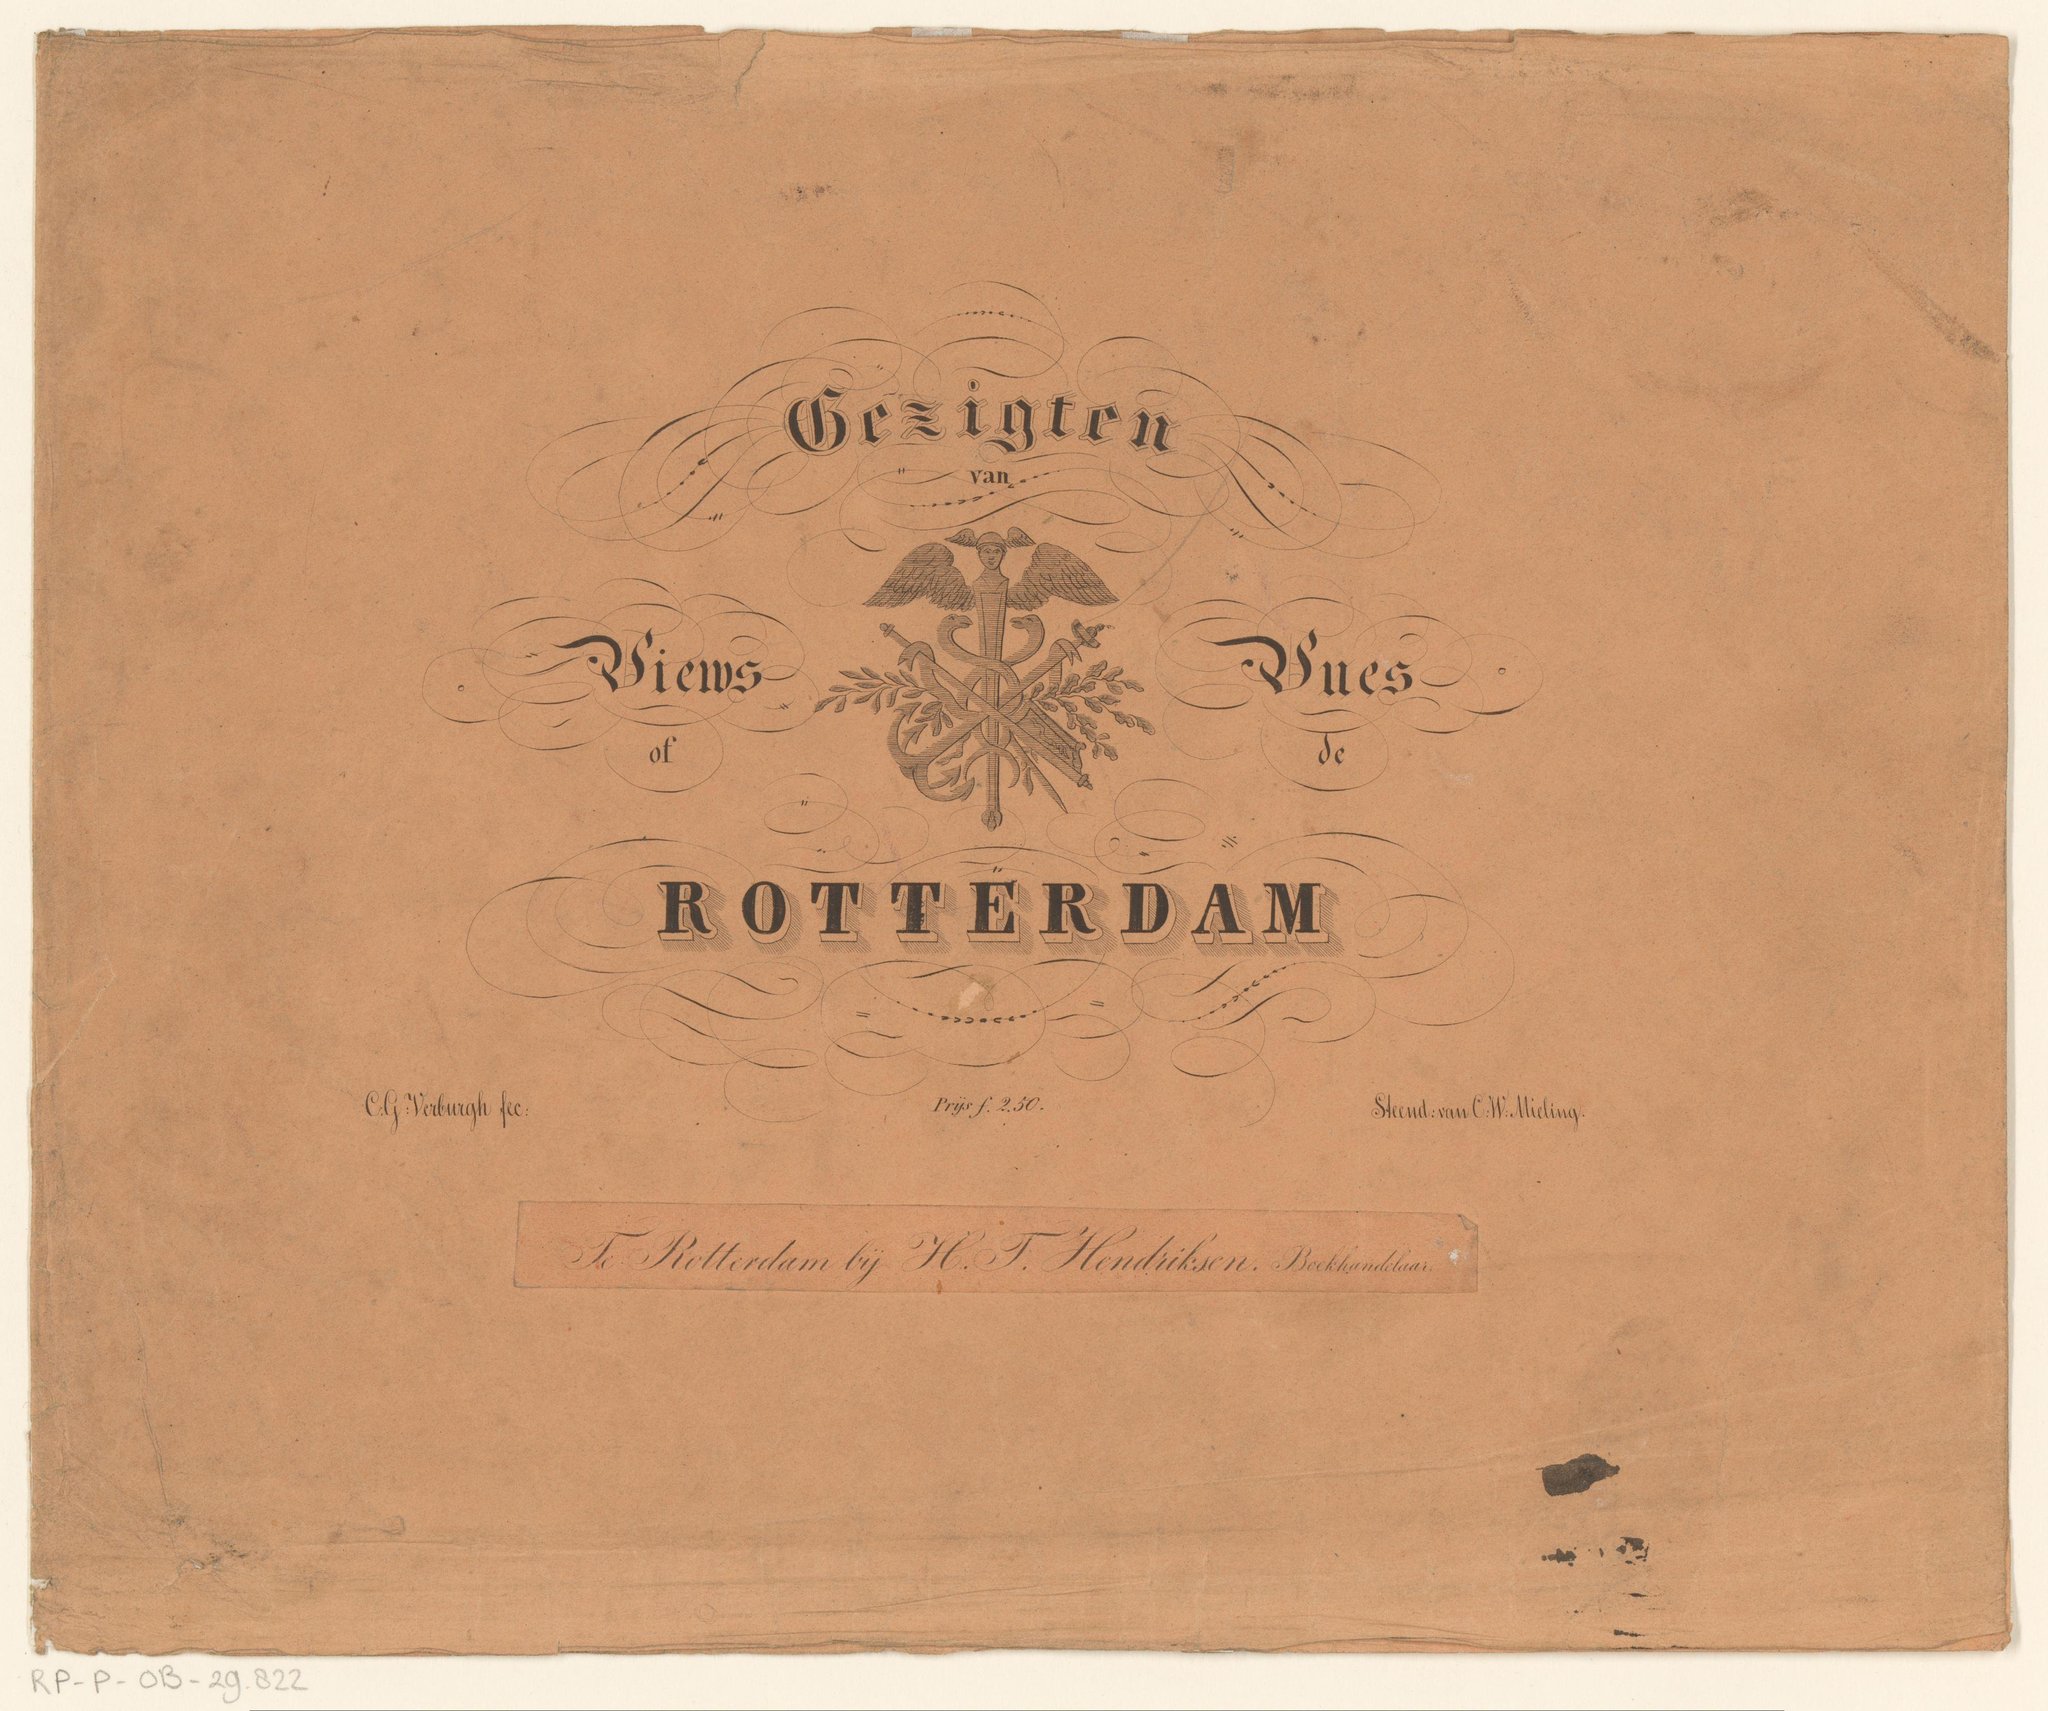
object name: print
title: Omslag voor serie gezichten op Rotterdam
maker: h.t. (boekhandelaar)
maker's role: publisher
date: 1839-1846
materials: paper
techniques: lithograph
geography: rotterdam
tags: city-view in general; 'veduta'